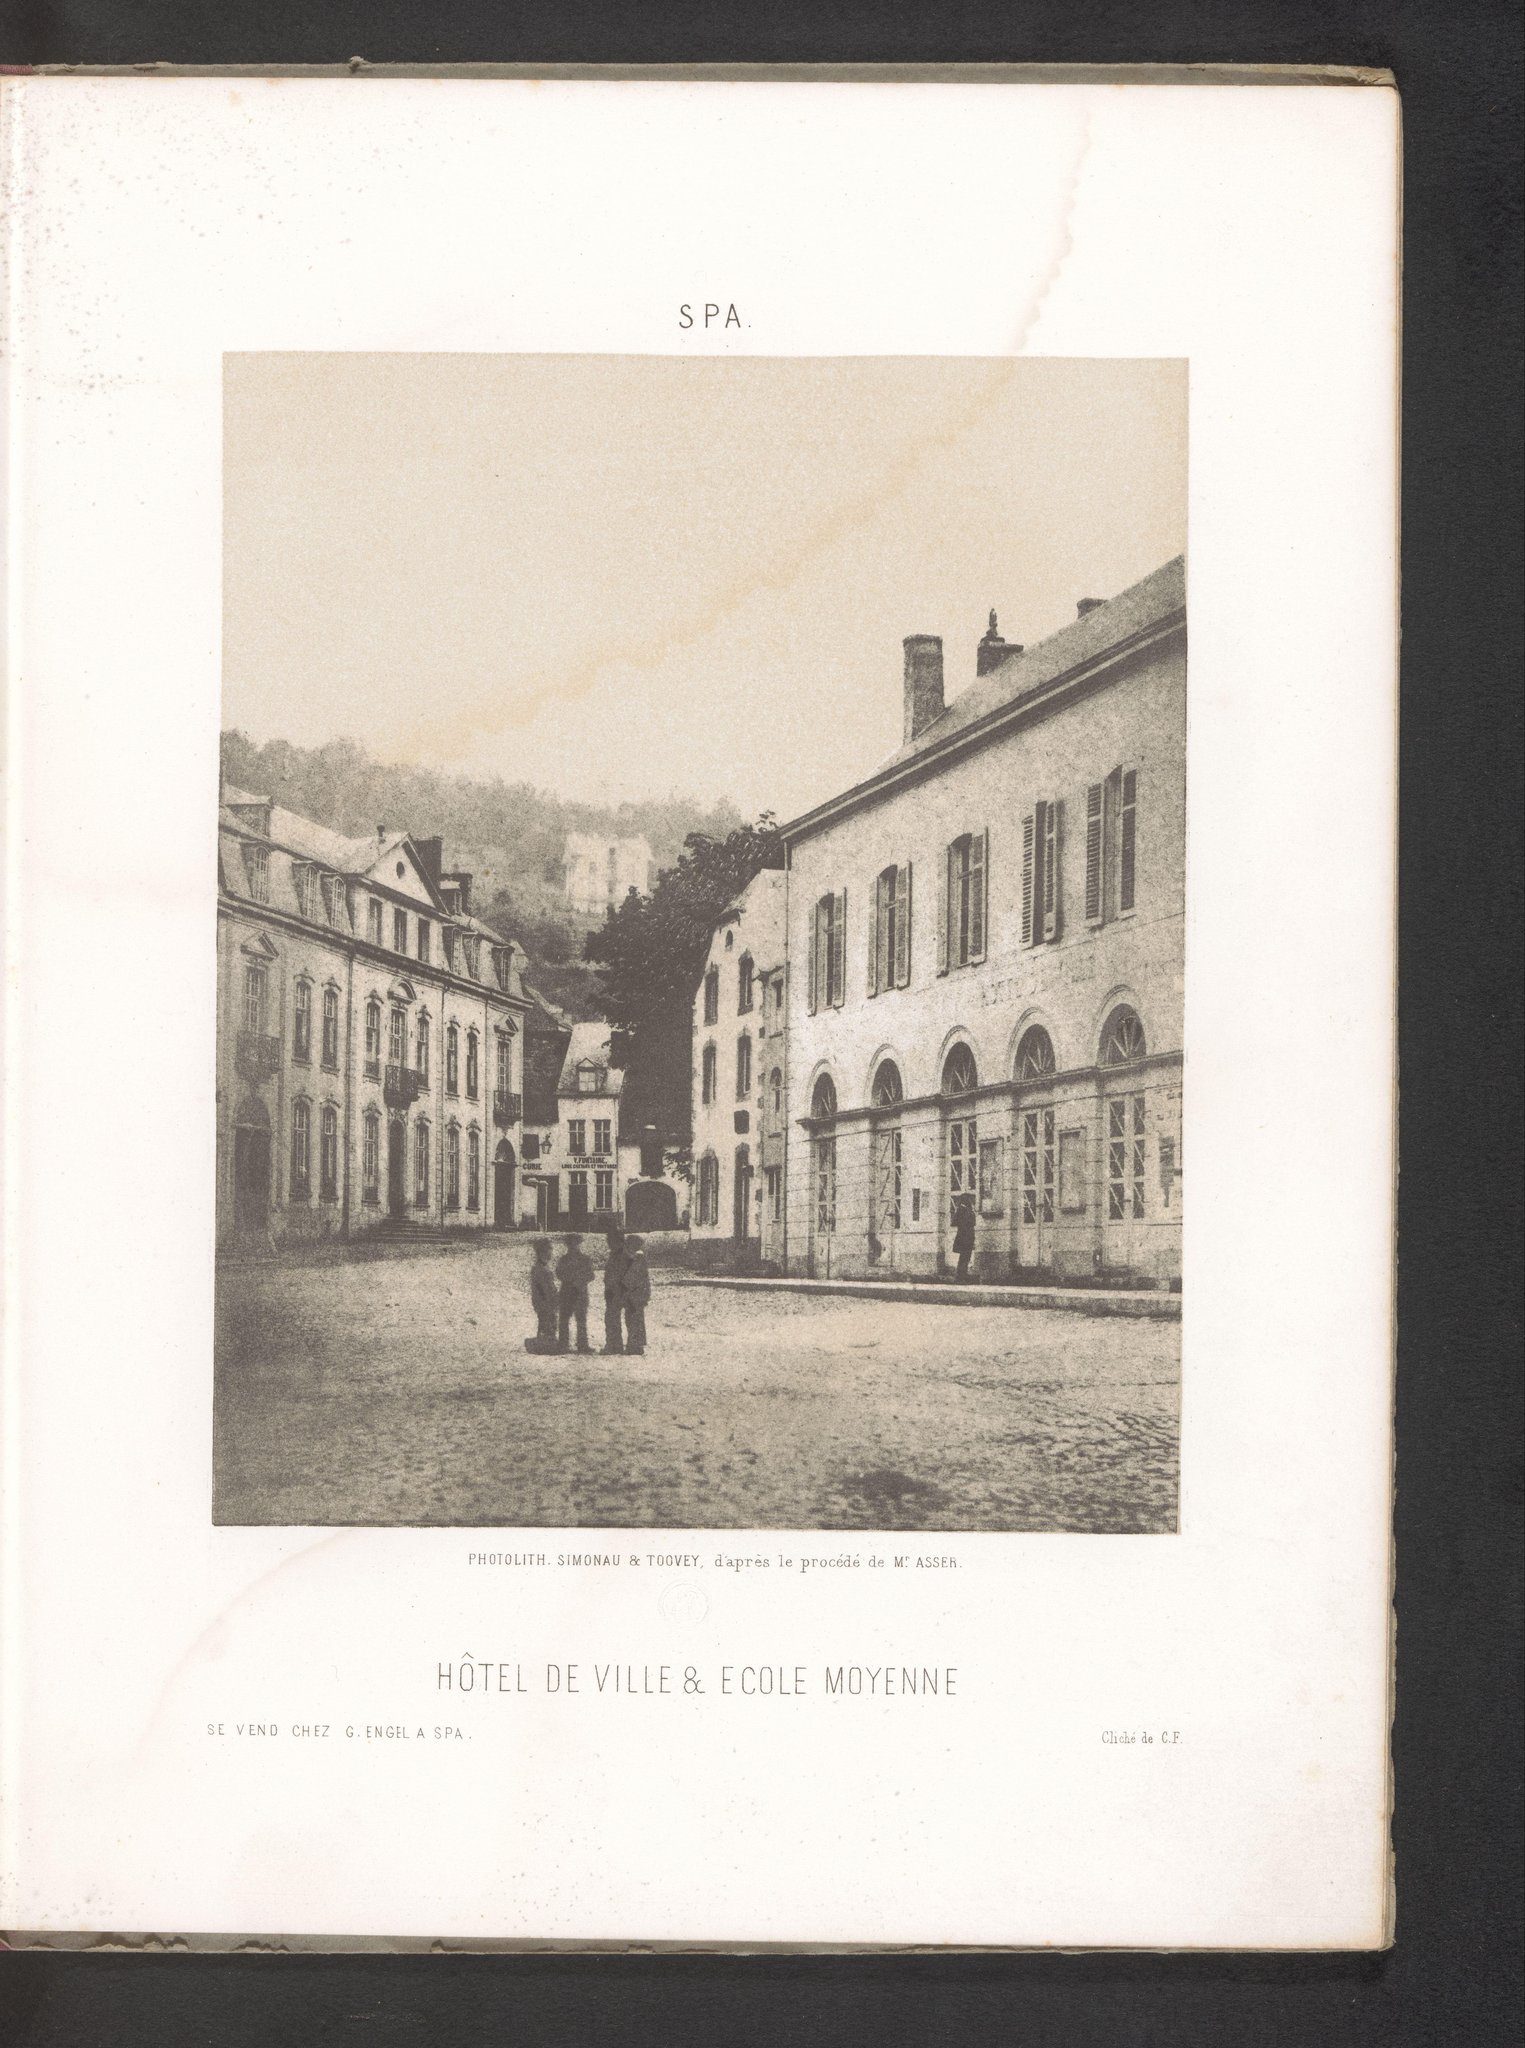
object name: page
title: Hôtel de Ville & Ecole Moyenne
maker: c.f.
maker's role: fotograaf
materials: paper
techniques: photolithography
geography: brussels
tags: secondary education, townhall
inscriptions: collector's mark: ‘EA’, inscription: ‘PHOTOLITH. SIMONAU & TOOVEY, d'après le procédé de Mr. ASSER.’, inscription: ‘SE VEND CHEZ F. ENGEL A SPA.’